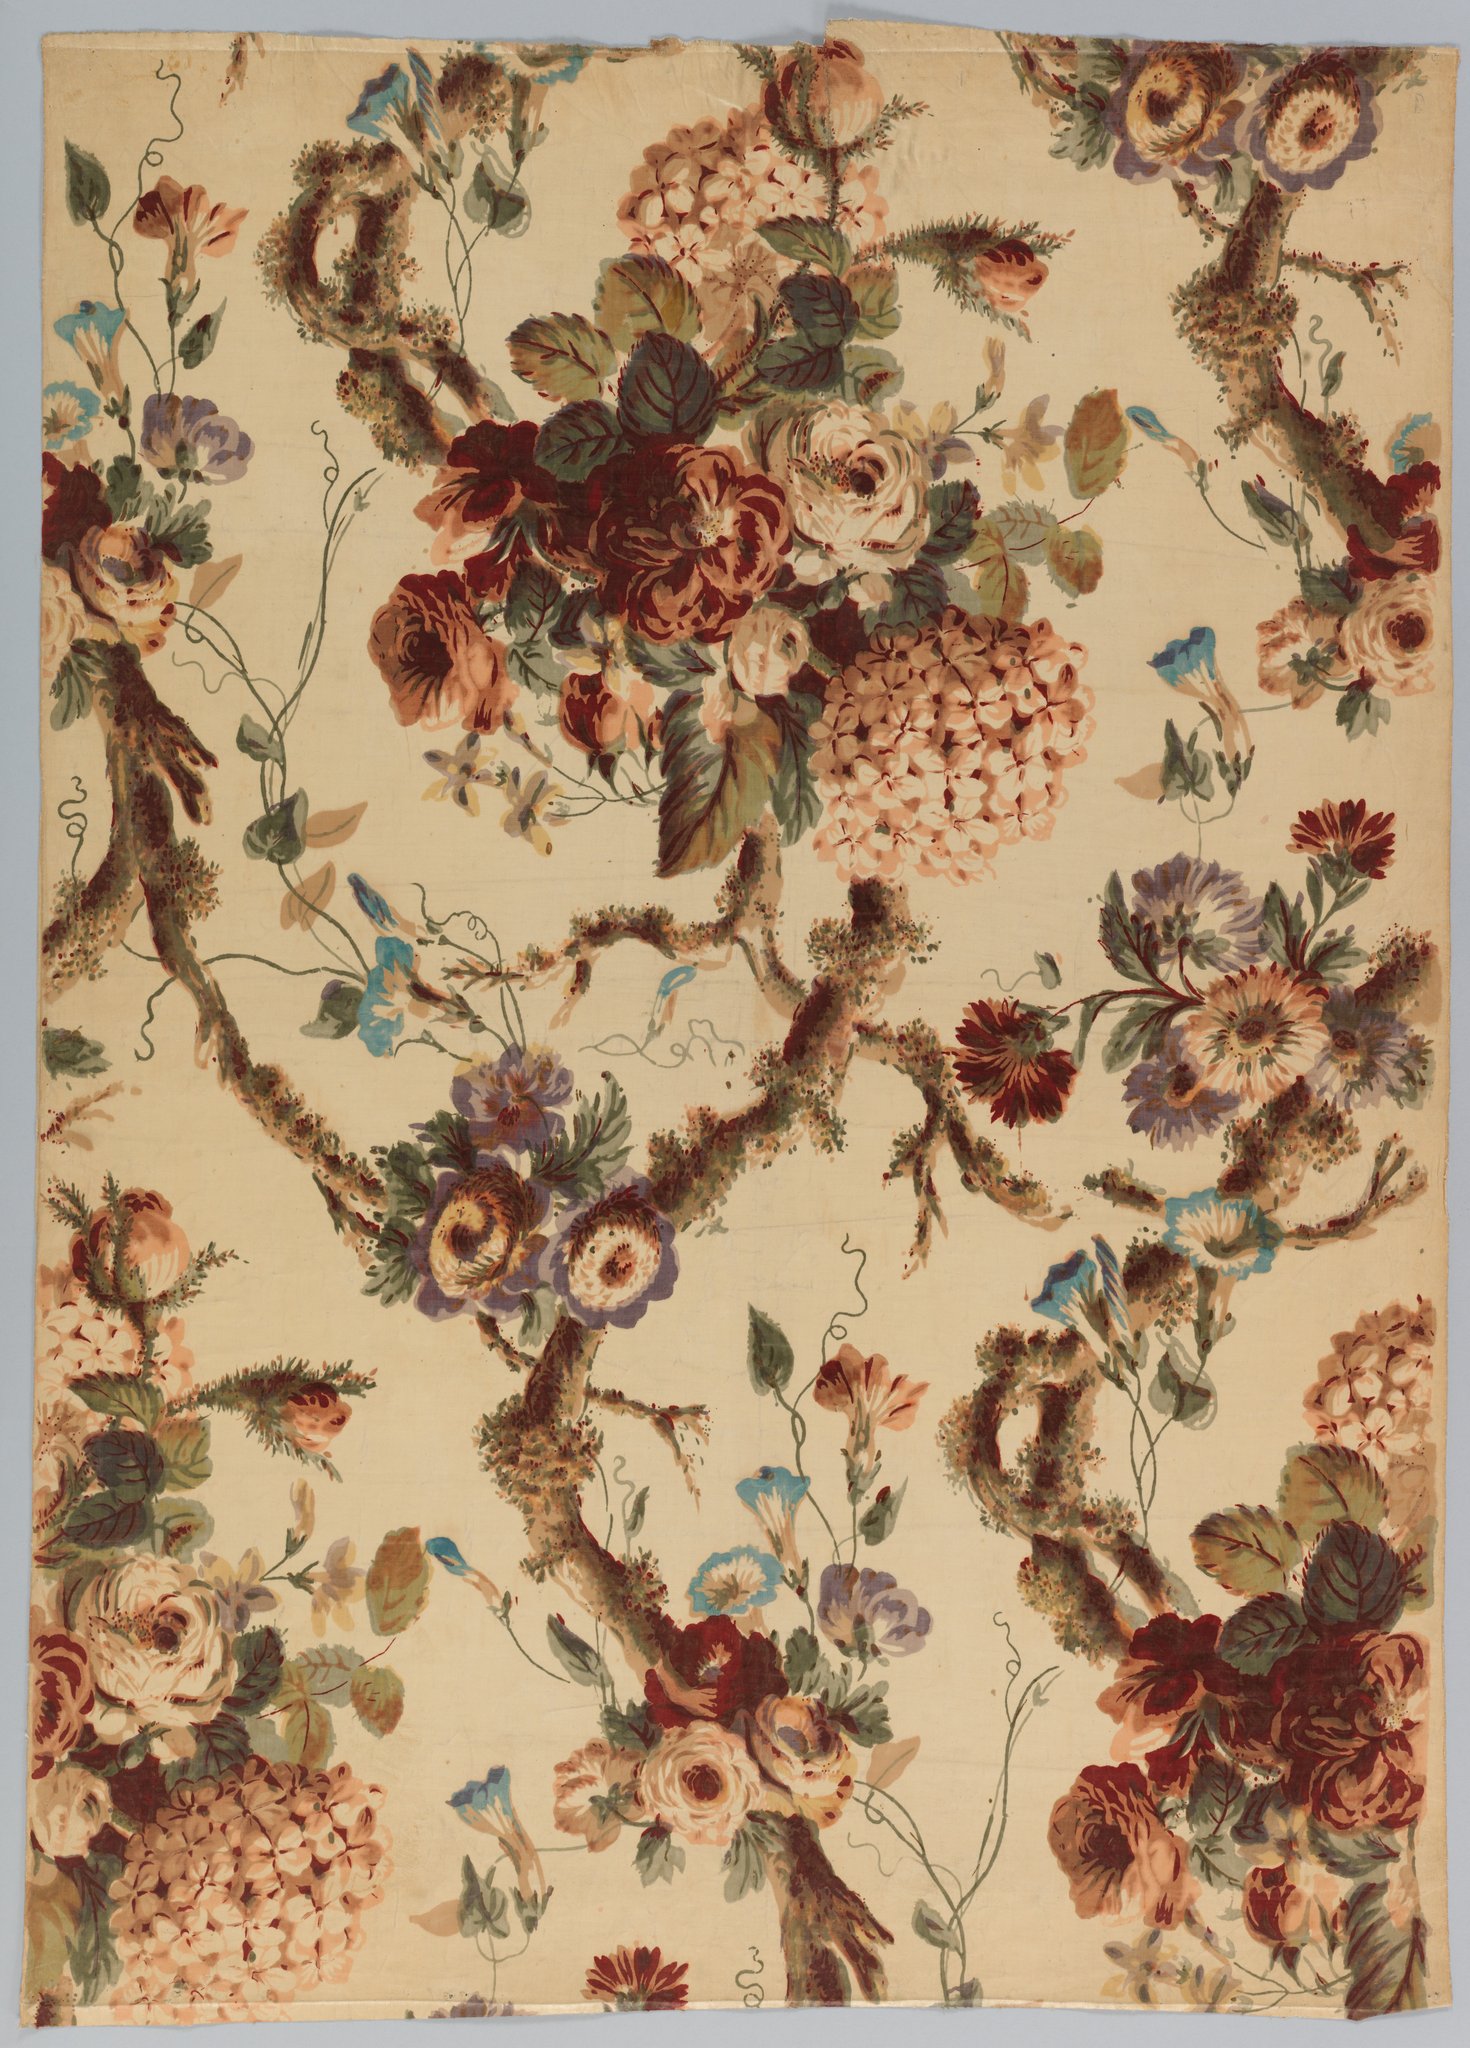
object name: piece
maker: stinton bros.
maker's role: designer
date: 1851-1872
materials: cotton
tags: roses